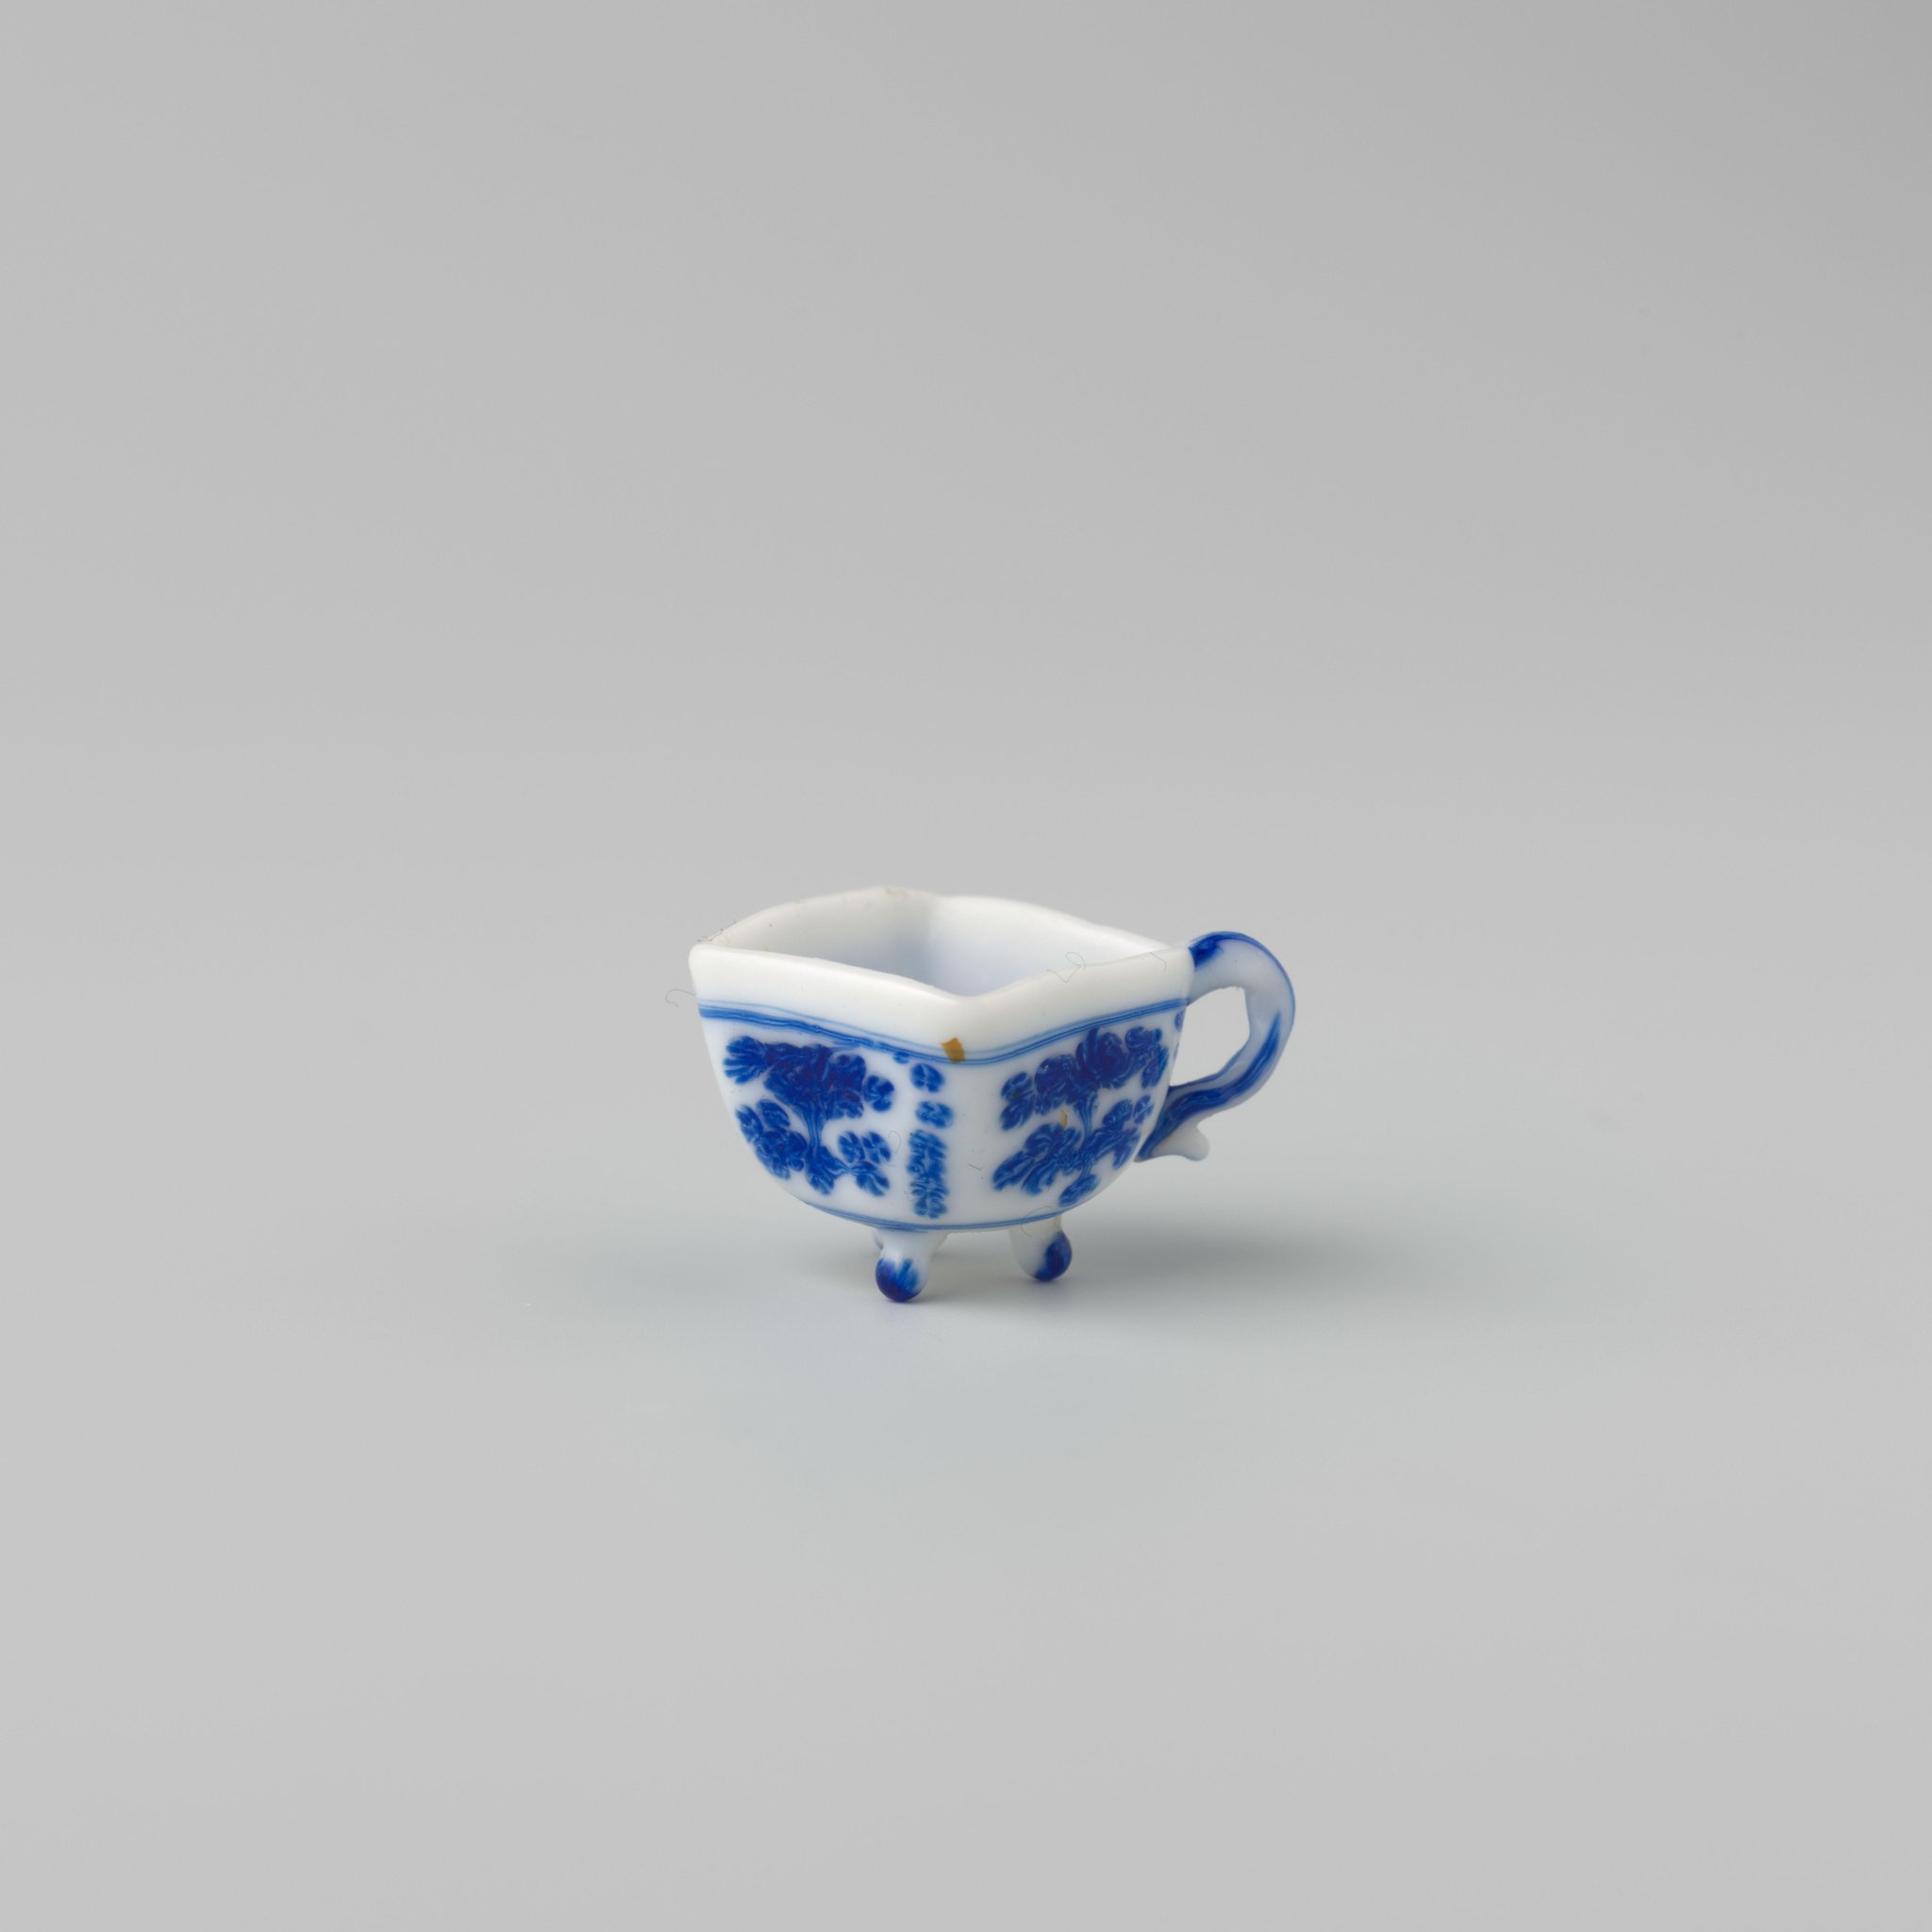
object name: miniature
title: Vuurtest van melkglas met blauwe emailverf beschildering, imitatie Chinees porselein; vierkant bakje op drie pootjes met oor; decoratie van bloemmotieven in vier vakken.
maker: Anonymous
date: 1675-1710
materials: glass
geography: amsterdam